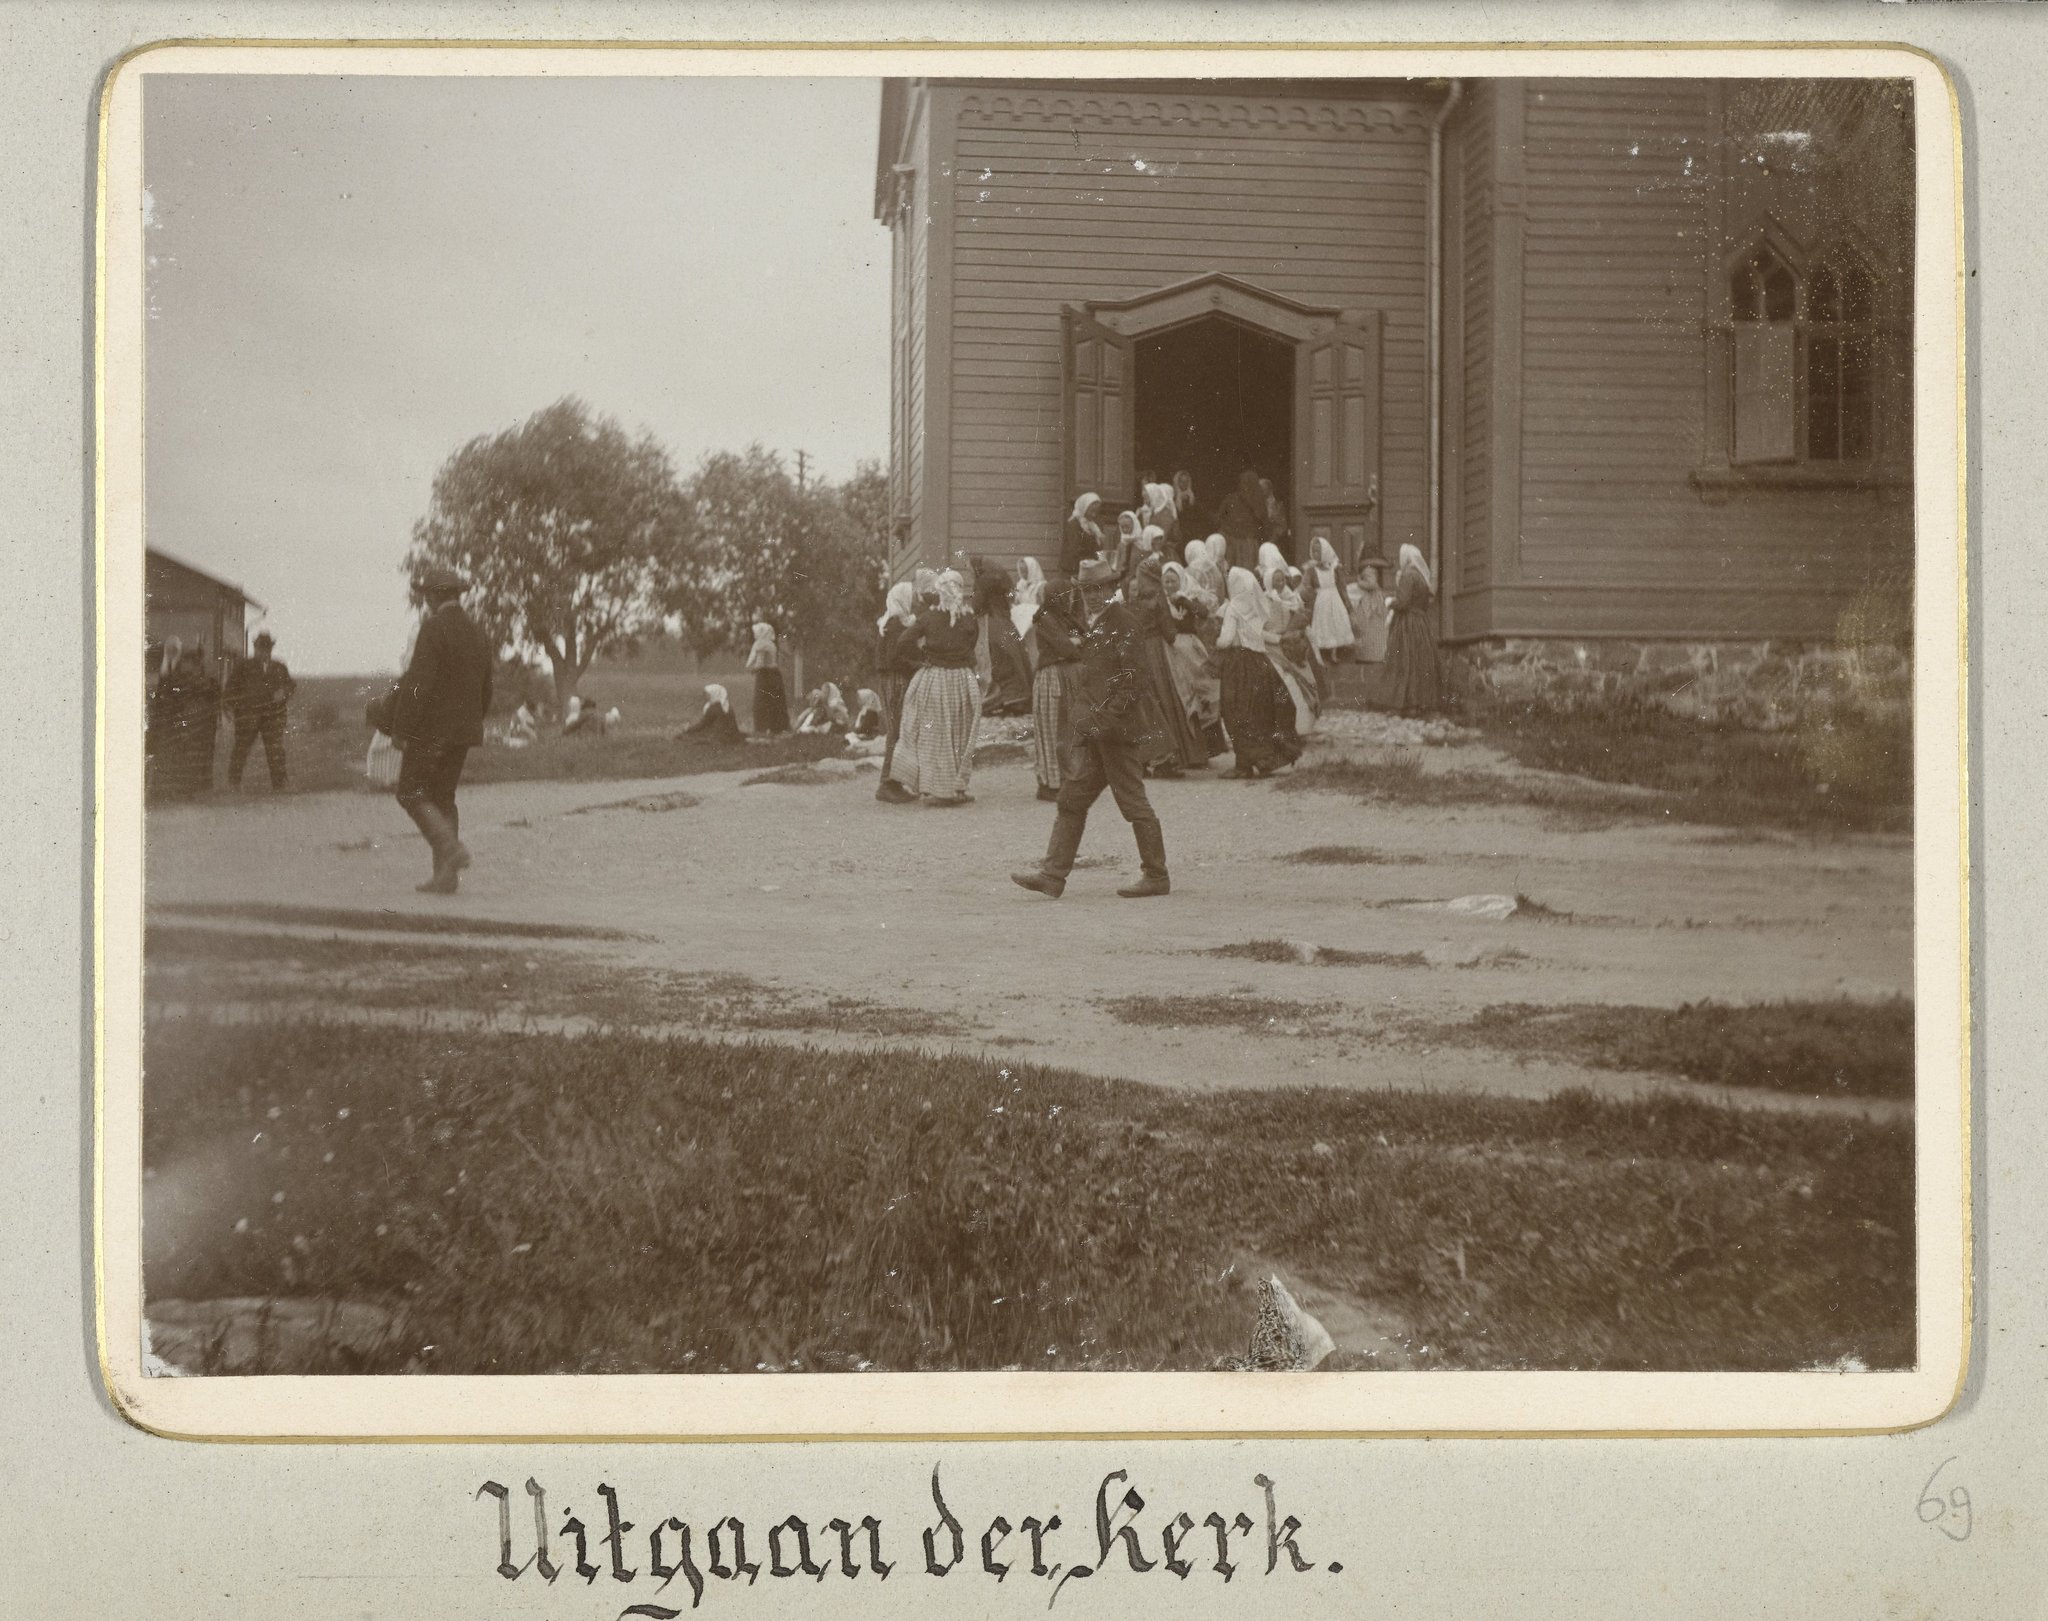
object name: photograph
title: Vilmanstrand Finland, uitgaan der kerk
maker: henry pauw van wieldrecht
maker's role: fotograaf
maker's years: 1863-1912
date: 1898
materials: paper, photographic support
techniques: albumen print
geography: netherlands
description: Het uitgaan van de kerk in Lappeenranta, Finland. De dames dragen allen lange rokken en hoofddoekjes, de heren een hoed.